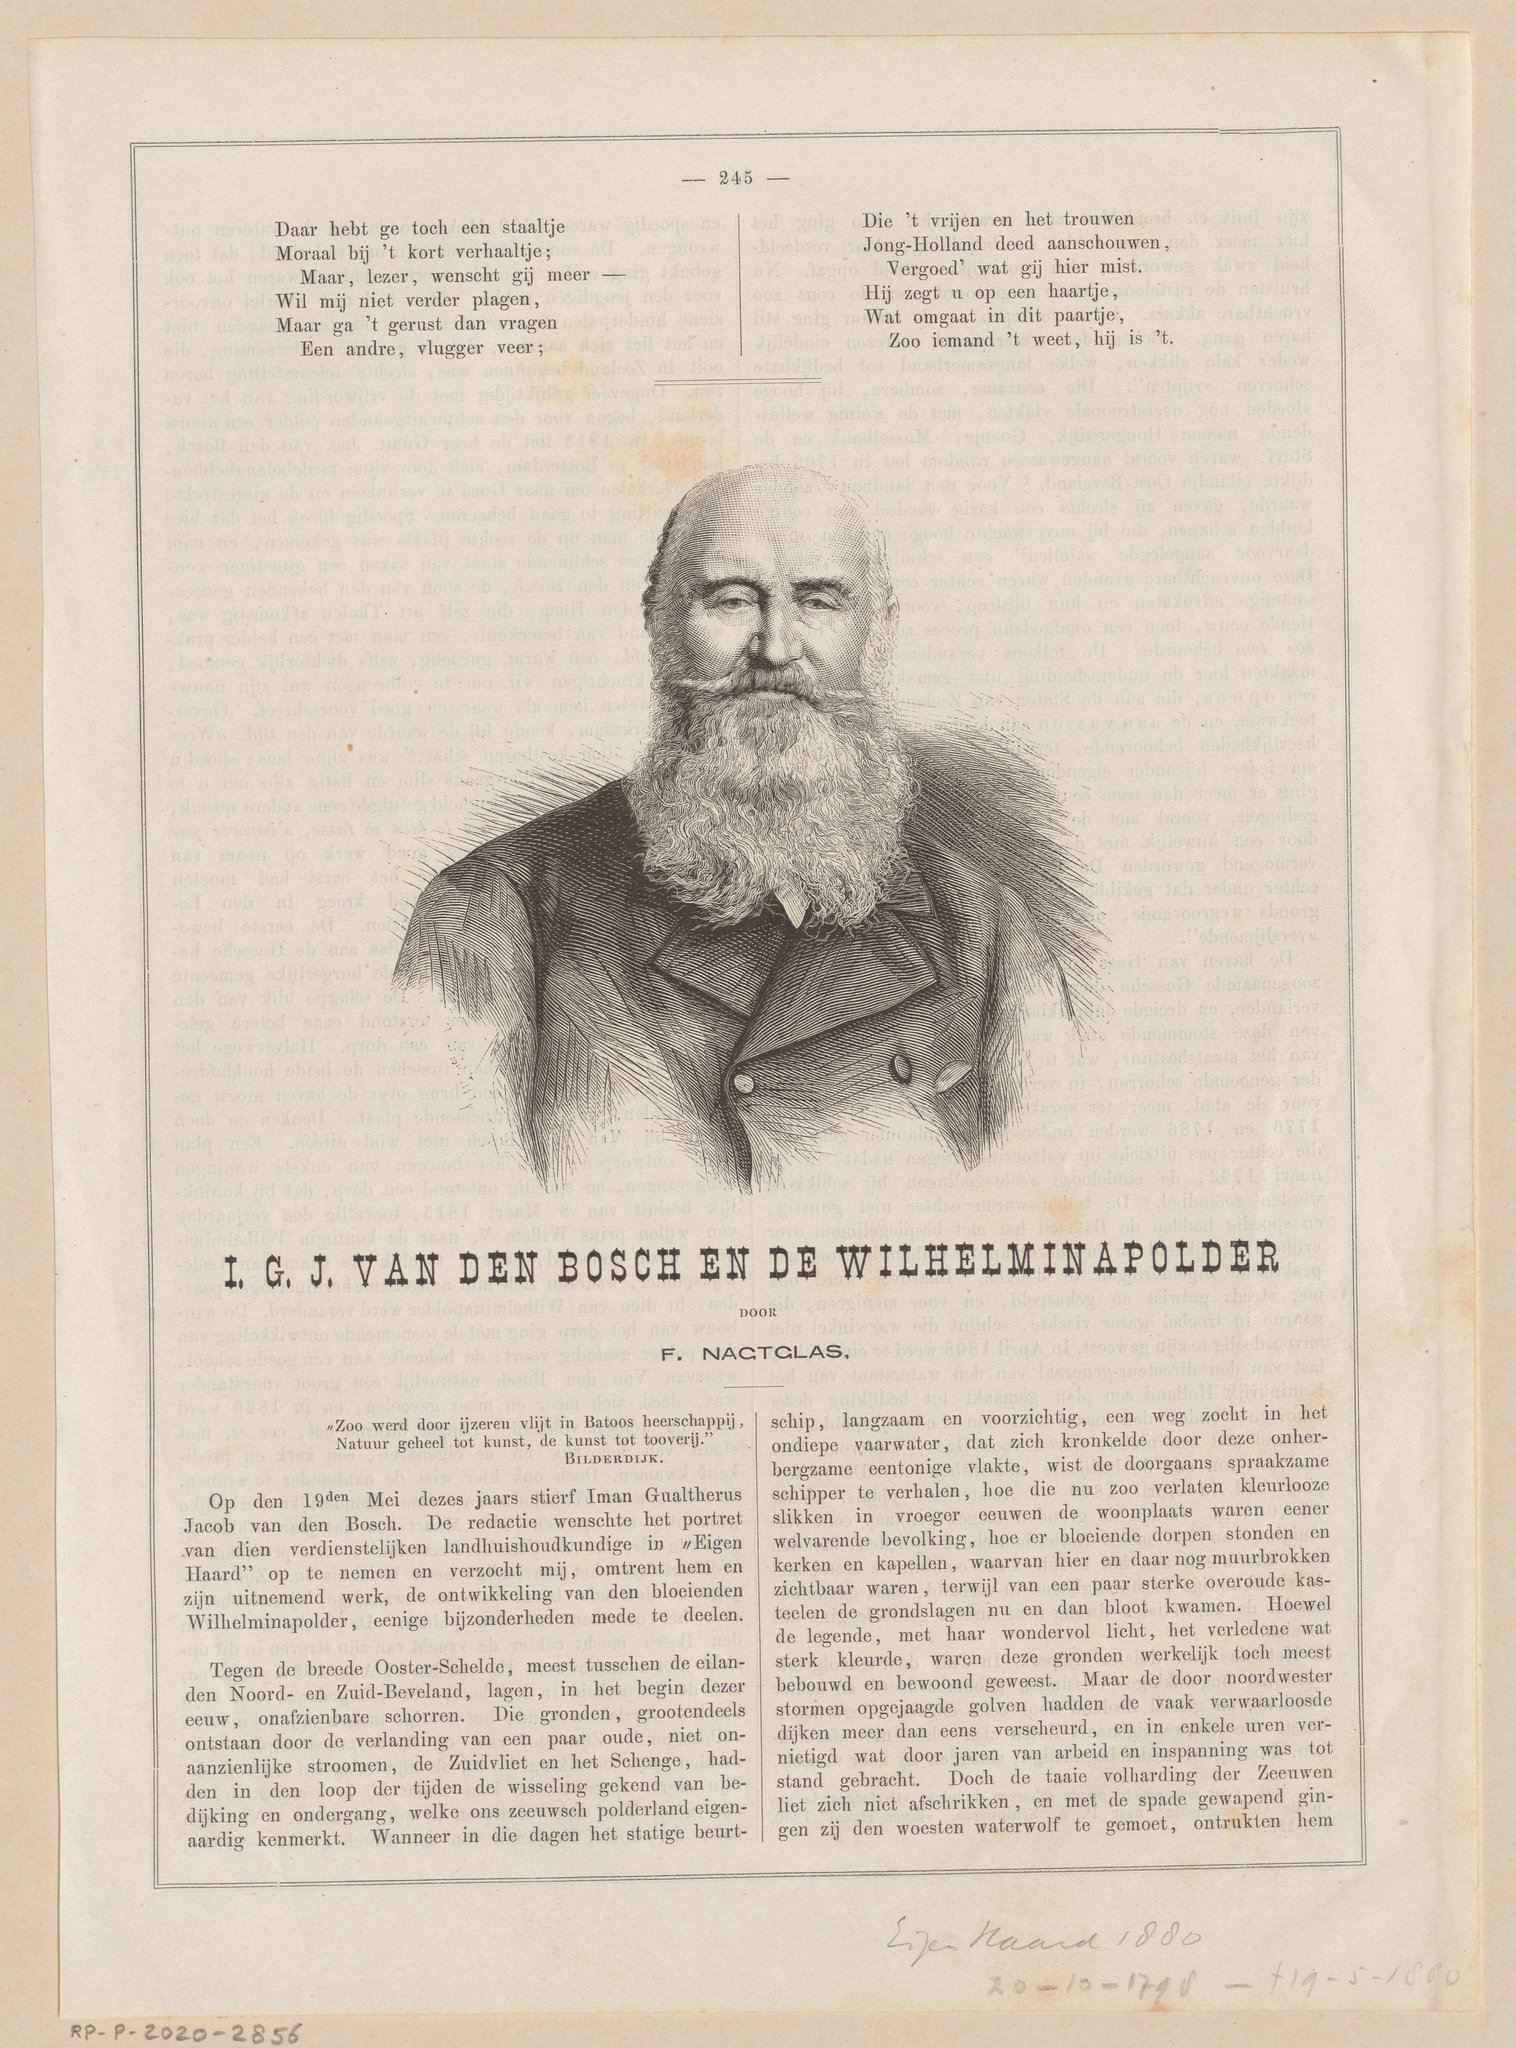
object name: print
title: Portret van Iman Gualtherus Jacob van den Bosch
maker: hermanus diedericus tjeenk willink (1843-1917)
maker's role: publisher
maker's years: 1843-1917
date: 1880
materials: paper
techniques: letterpress printing, engraving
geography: haarlem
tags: rotterdam, historical persons